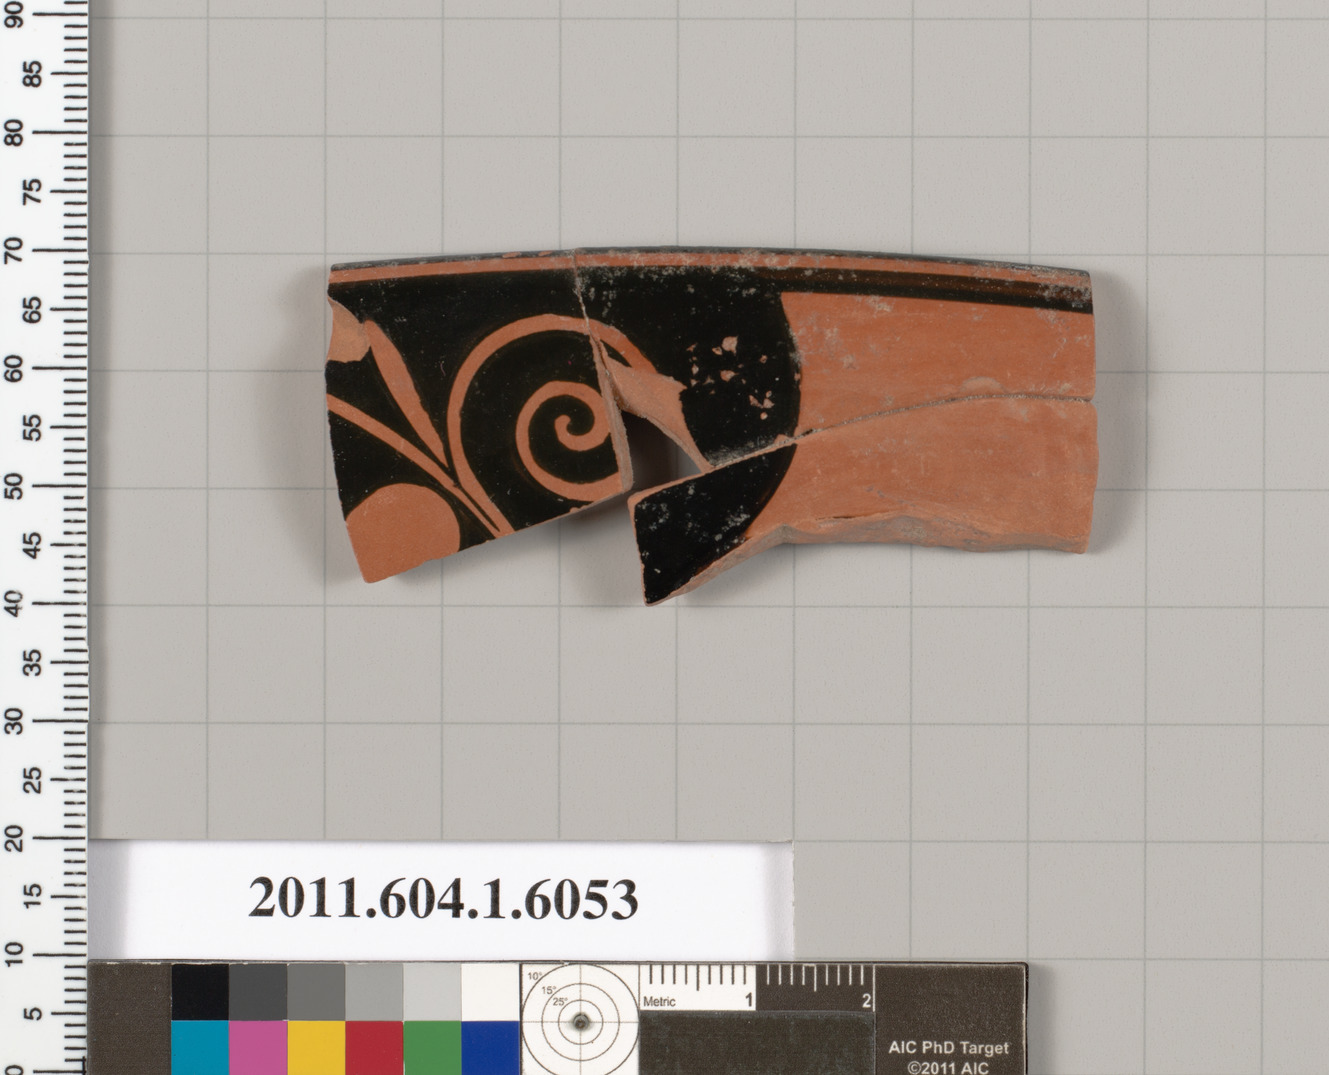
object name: kylix fragment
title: Terracotta rim fragment of a kylix (drinking cup)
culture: greek, attic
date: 510-500 BCE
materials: terracotta